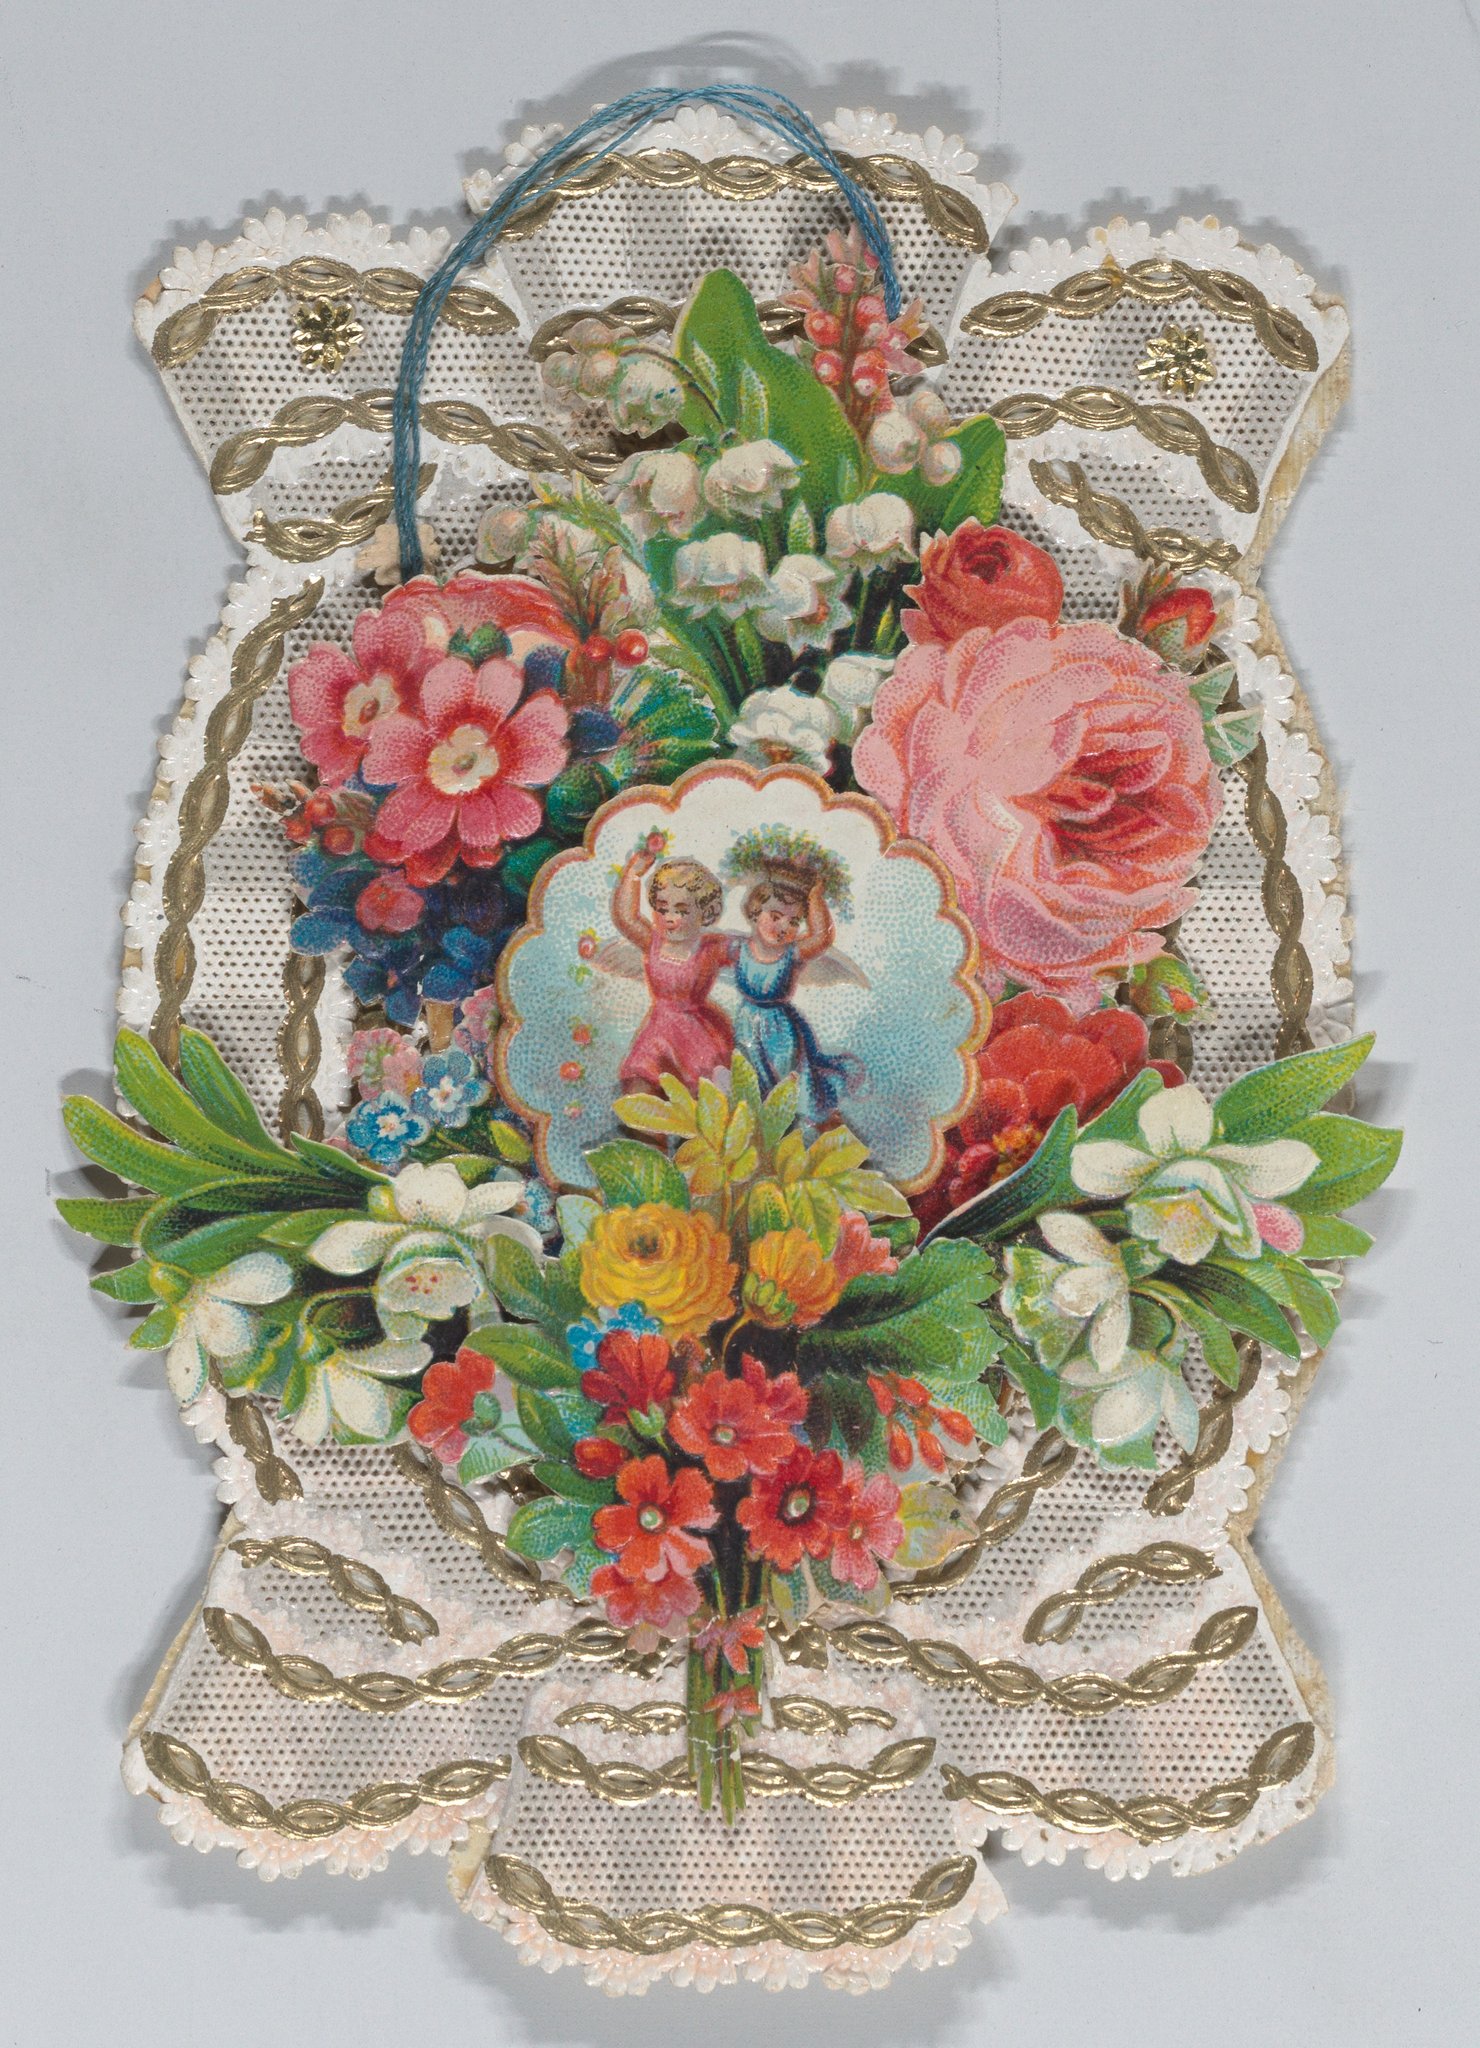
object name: valentine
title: Valentine - Mechanical - cluster of lace paper, die cuts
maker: anonymous, british, 19th century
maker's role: artist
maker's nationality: british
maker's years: 1800-1900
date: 1875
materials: lace, paper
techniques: cutting, gilding, open work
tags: flowers,angels